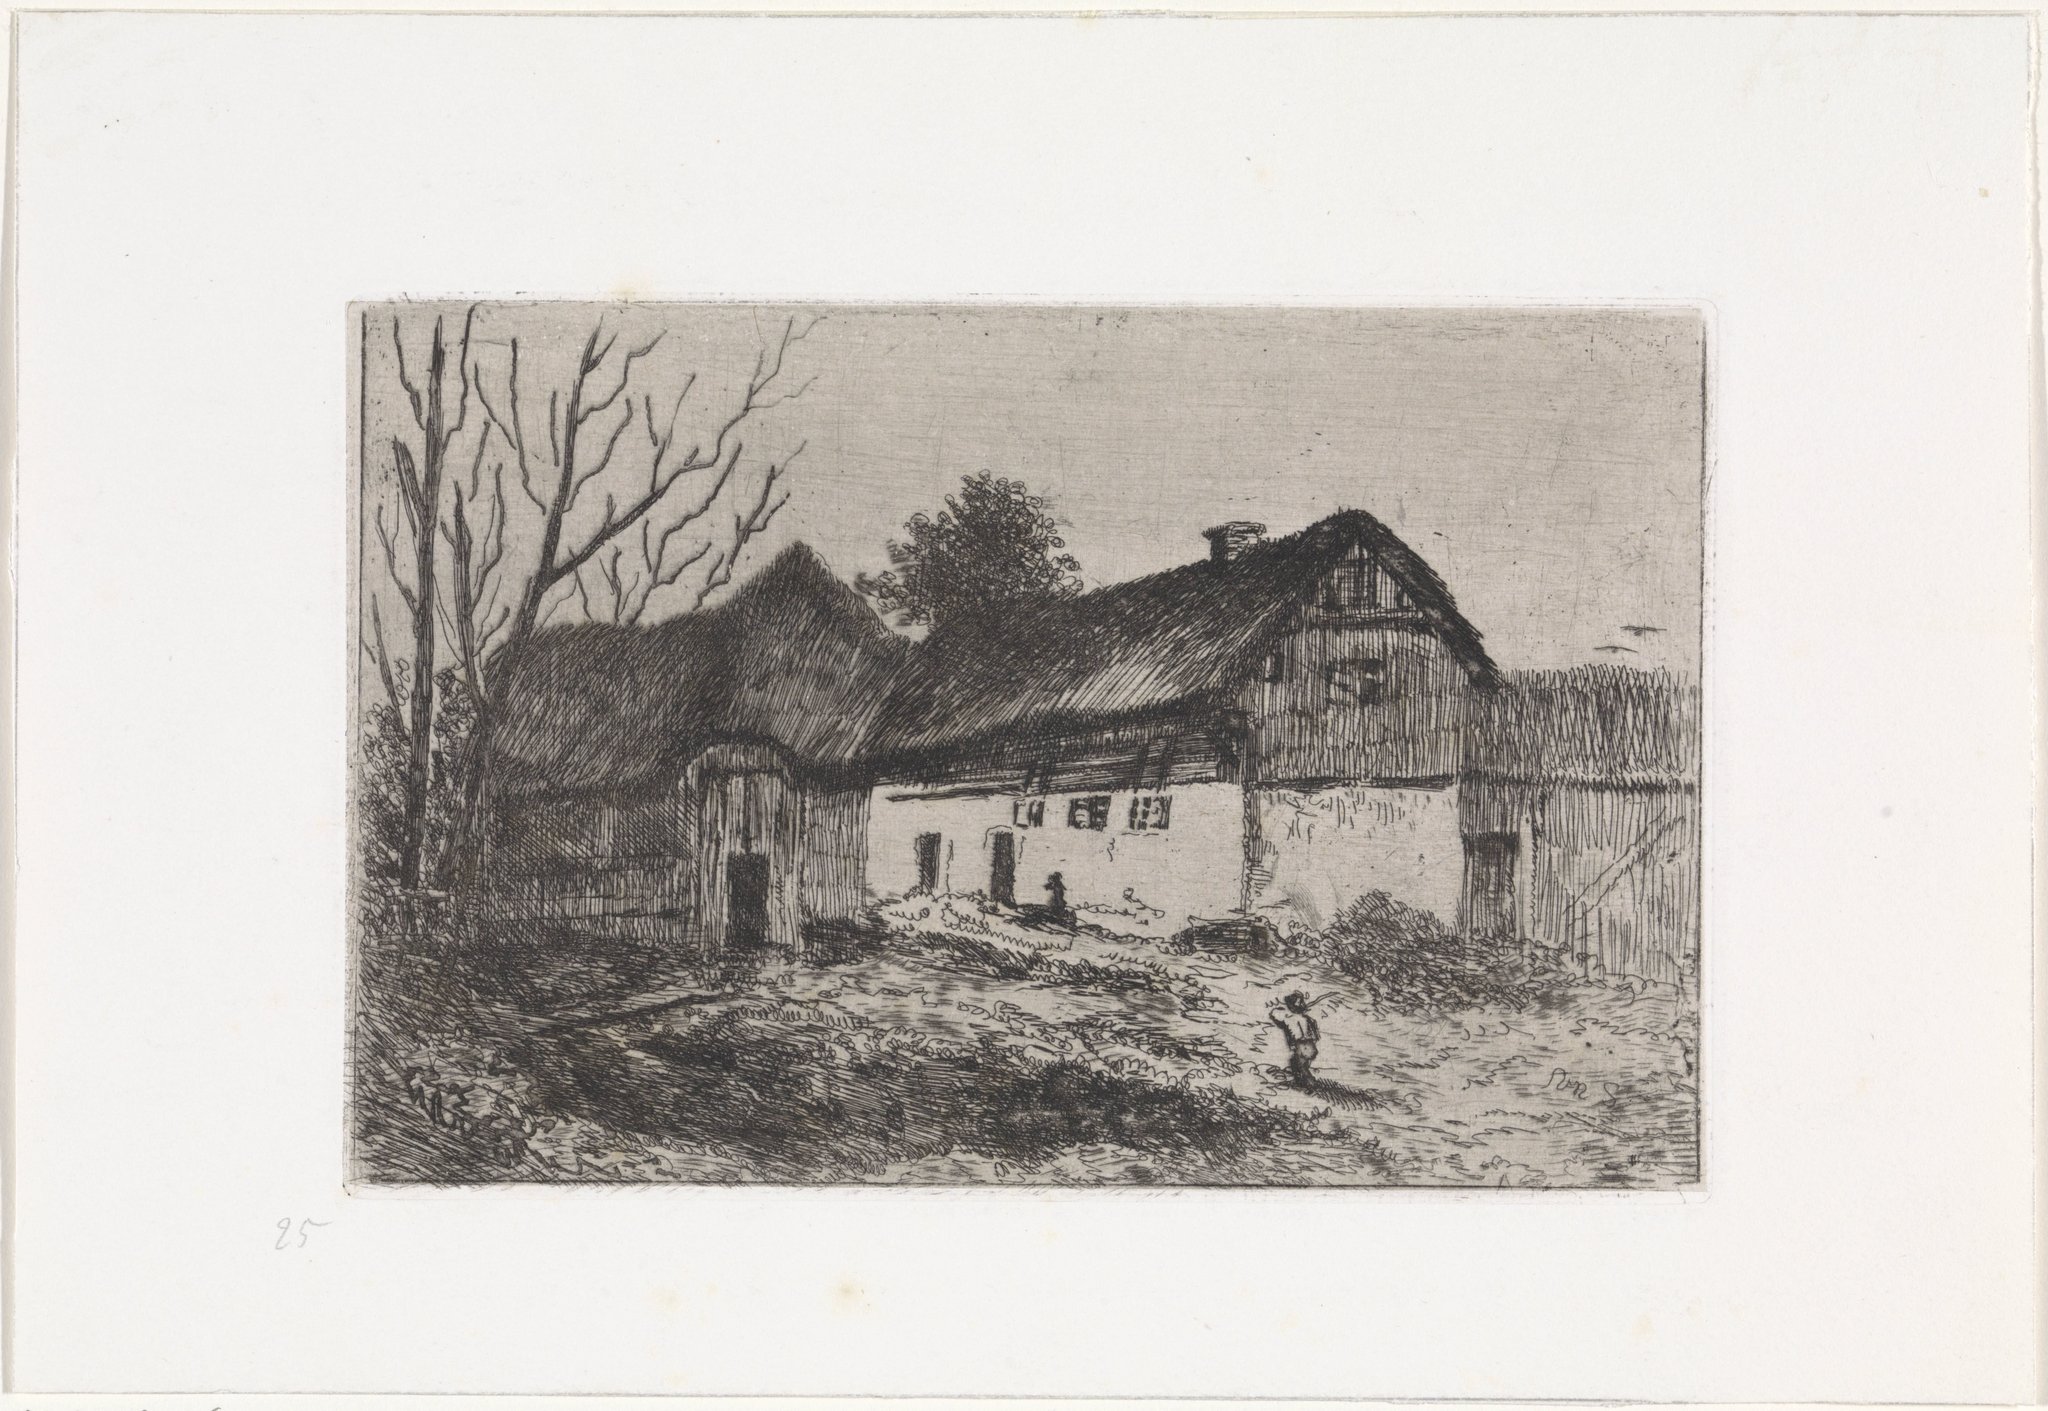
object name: print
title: Boerderij met schuur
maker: arnoud schaepkens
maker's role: print maker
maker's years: 1816-1904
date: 1855-1904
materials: paper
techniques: drypoint, etching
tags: farm or solitary house in landscape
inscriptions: collector's mark: Lugt 2228